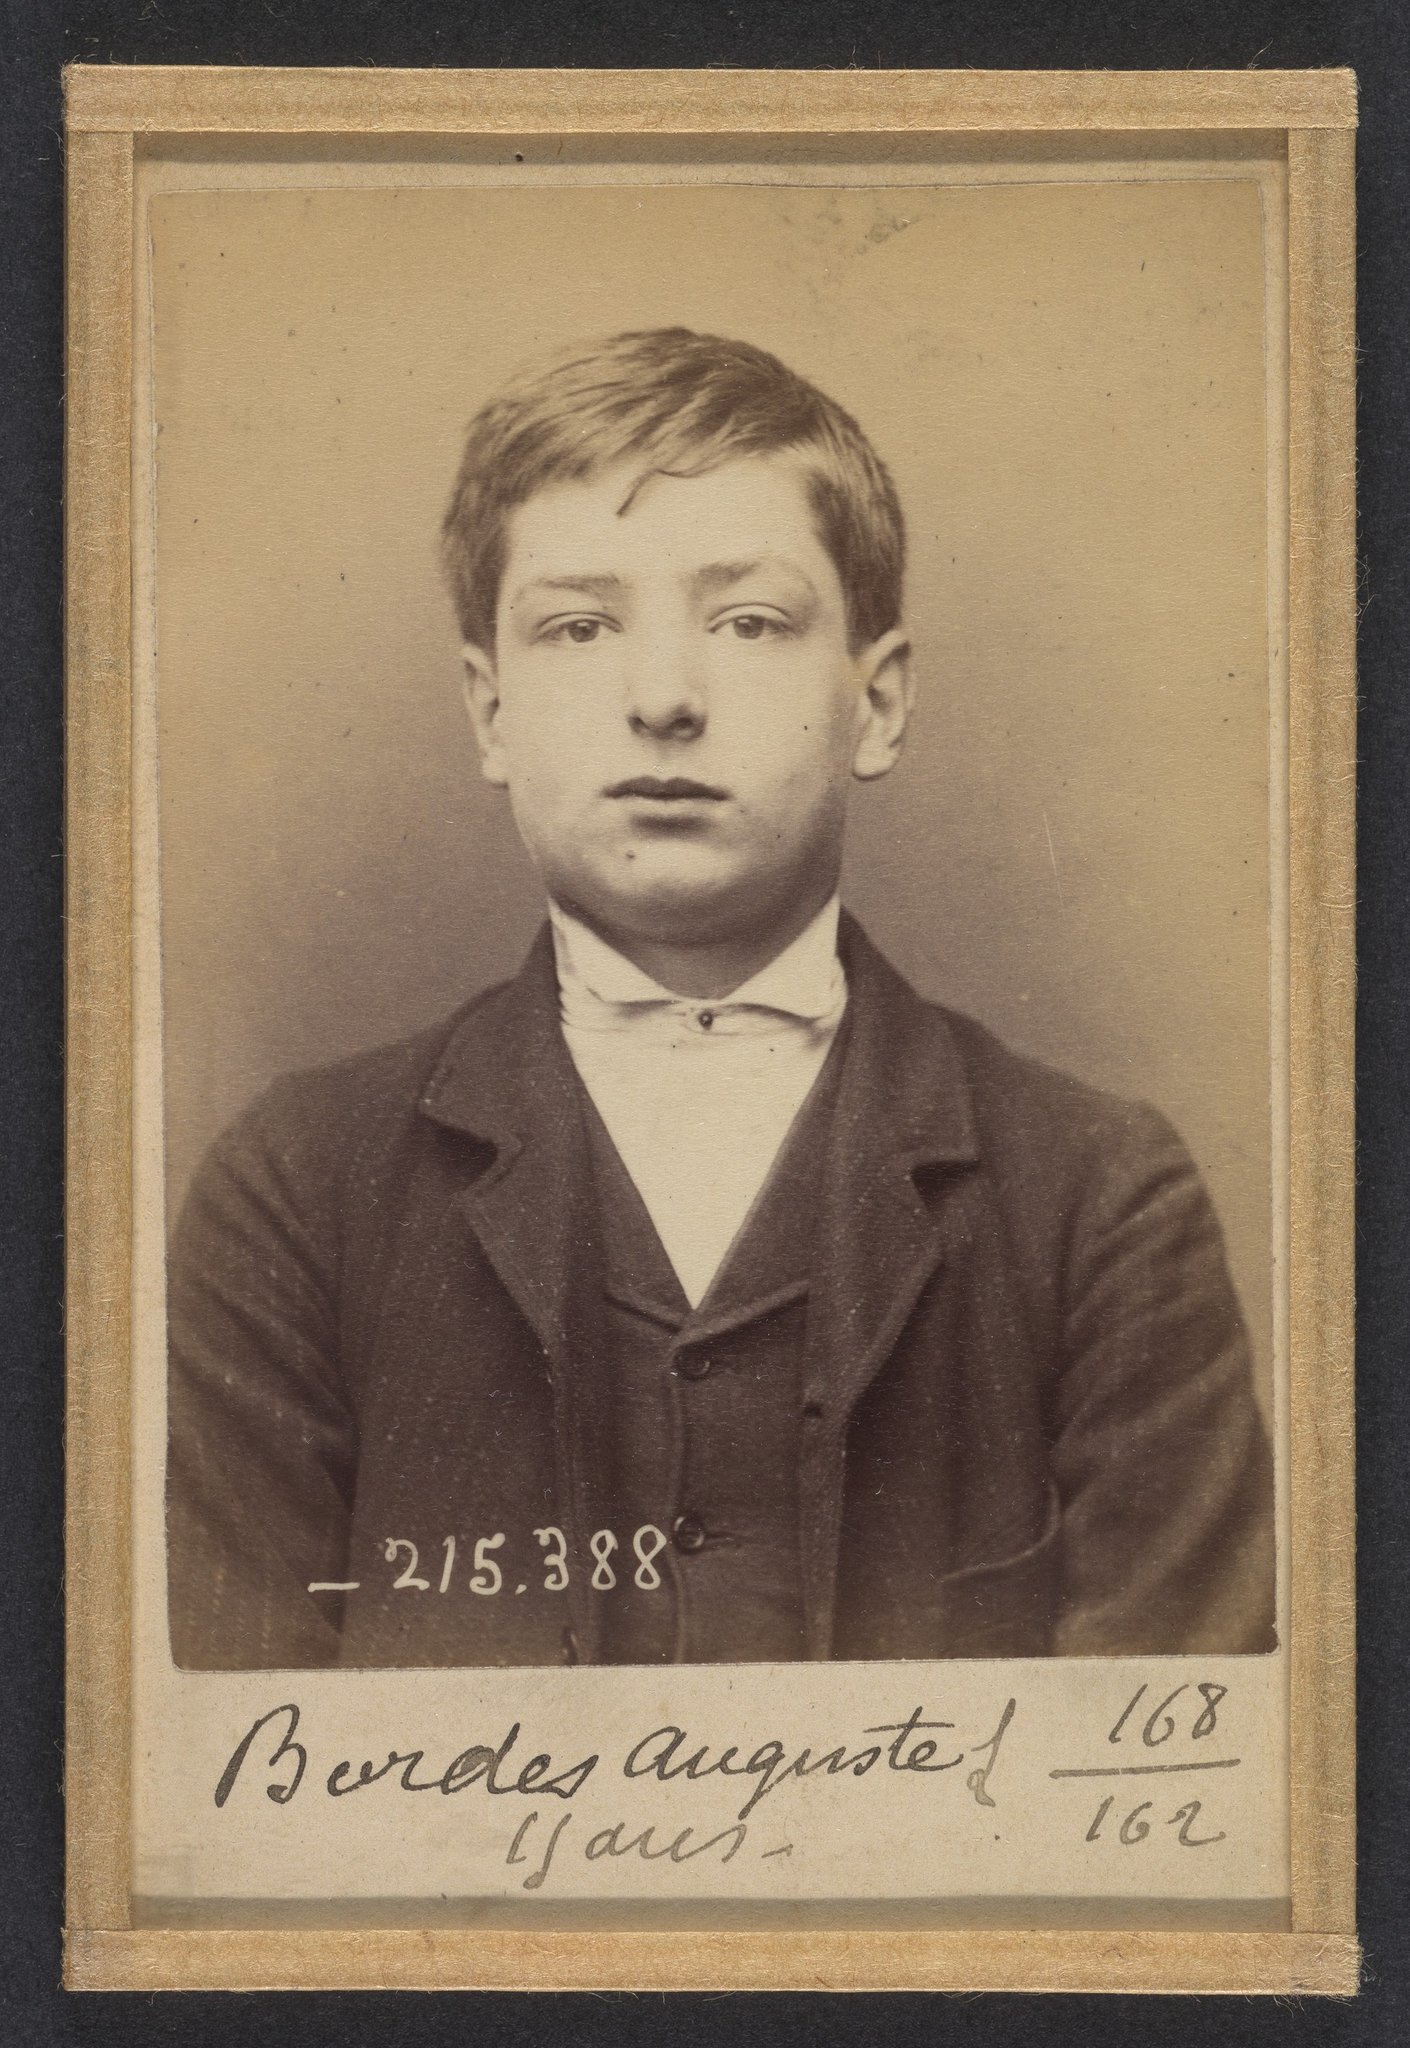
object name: mugshot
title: Bordes. Auguste. 15 ans, né à Paris XVIIIe. Garçon Marchand de vins. Anarchiste. 9/3/94.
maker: alphonse bertillon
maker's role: artist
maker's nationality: french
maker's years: 1853-1914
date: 1894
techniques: albumen silver print, glass negative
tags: men,portraits